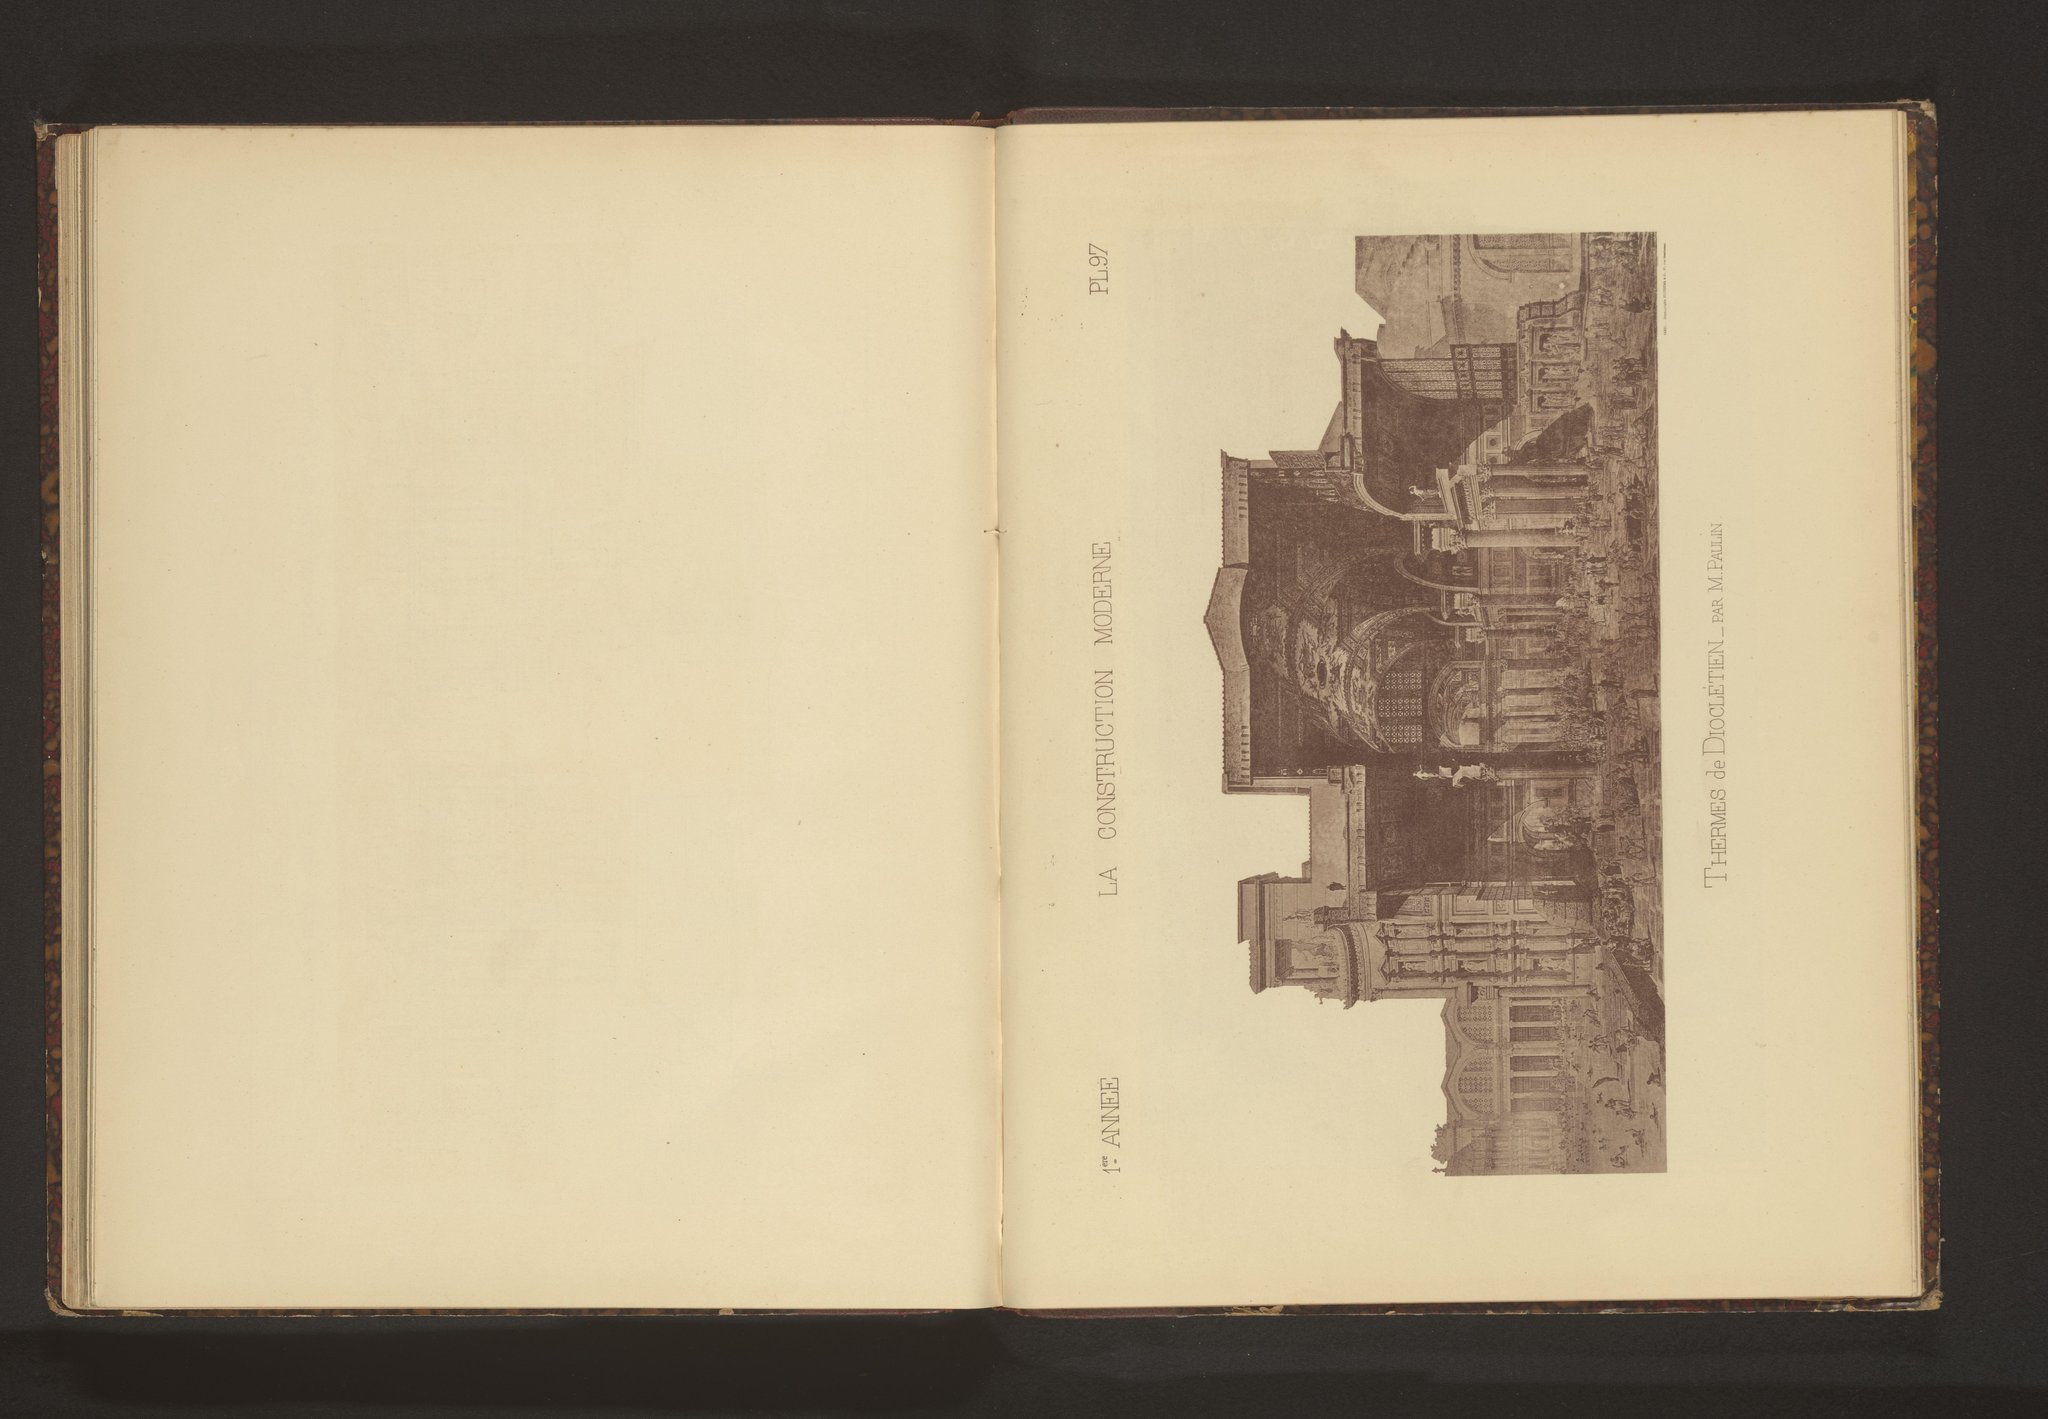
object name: photomechanical print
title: Reproductie van een ontwerp van de Baden van Diocletianus door Edmond Paulin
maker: edmond paulin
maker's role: draughtsman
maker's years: 1848-1915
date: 1881-1886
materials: paper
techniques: photograph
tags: public baths, rome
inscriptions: inscription: ‘par M. Paulin’, address: ‘PARIS - Glyptographie SILVESTRE & Cie, 97, rue Oberkampf.’, inscription: ‘1ère Année: LA CONSTRUCTION MODERNE Pl. 97’